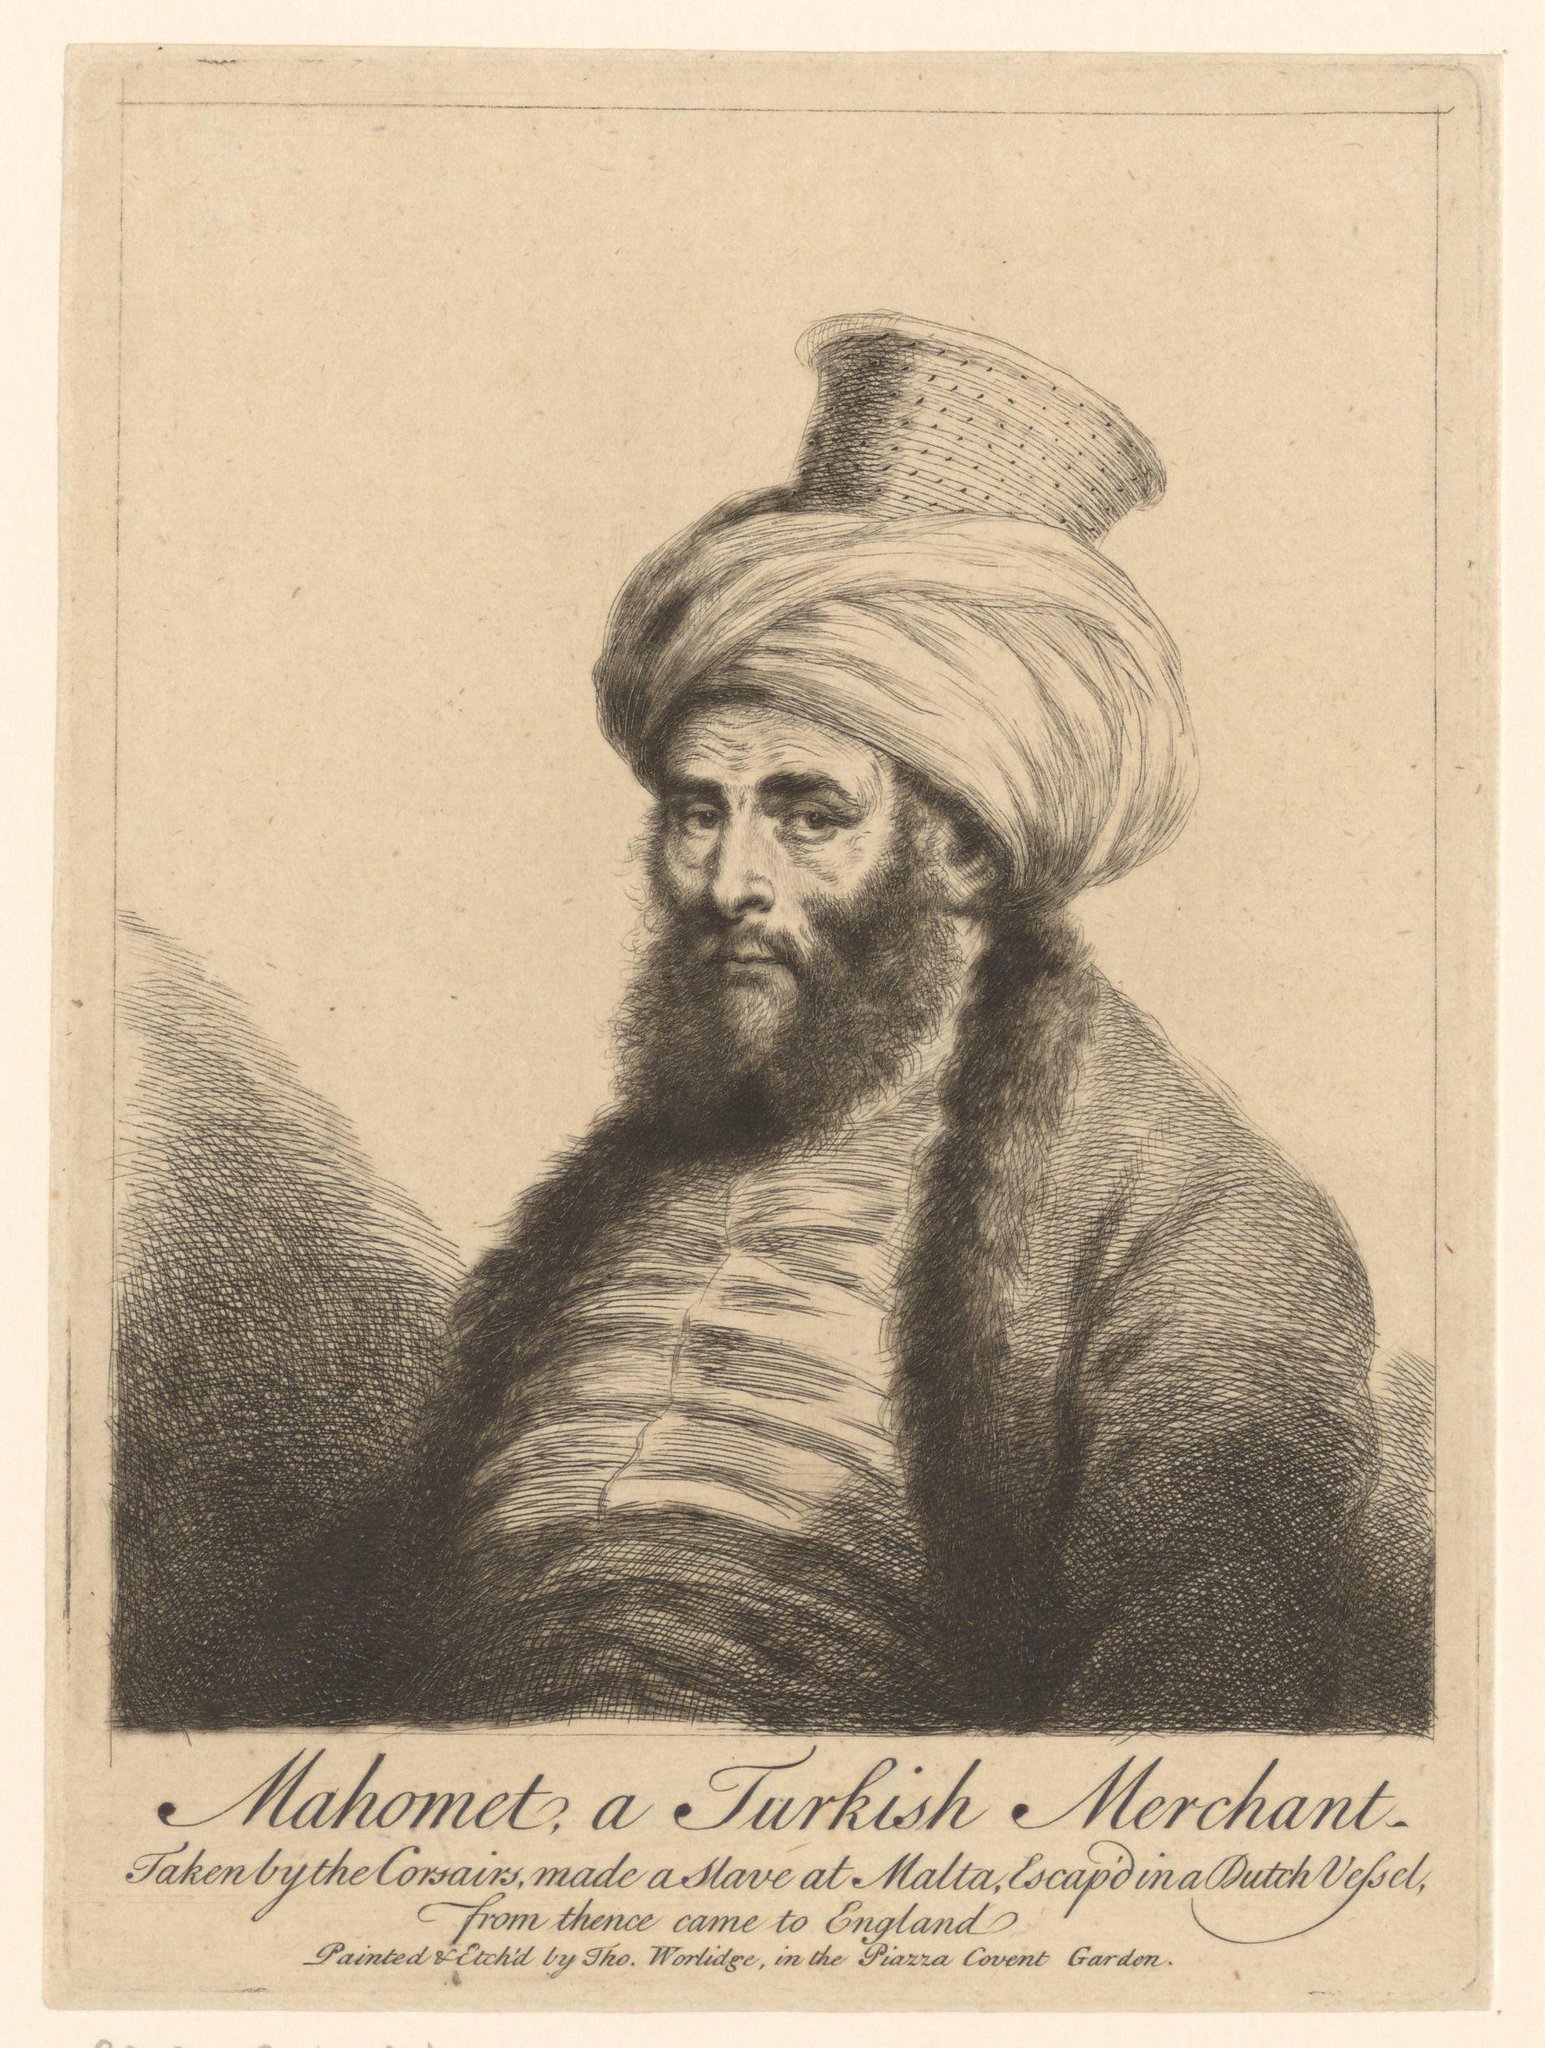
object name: print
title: Mahomet, a Turkish Merchant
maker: thomas worlidge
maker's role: print maker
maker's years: 1700-1766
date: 1710-1766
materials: paper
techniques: drypoint, etching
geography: london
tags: historical persons, merchant, salesman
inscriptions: collector's mark: Lugt 240